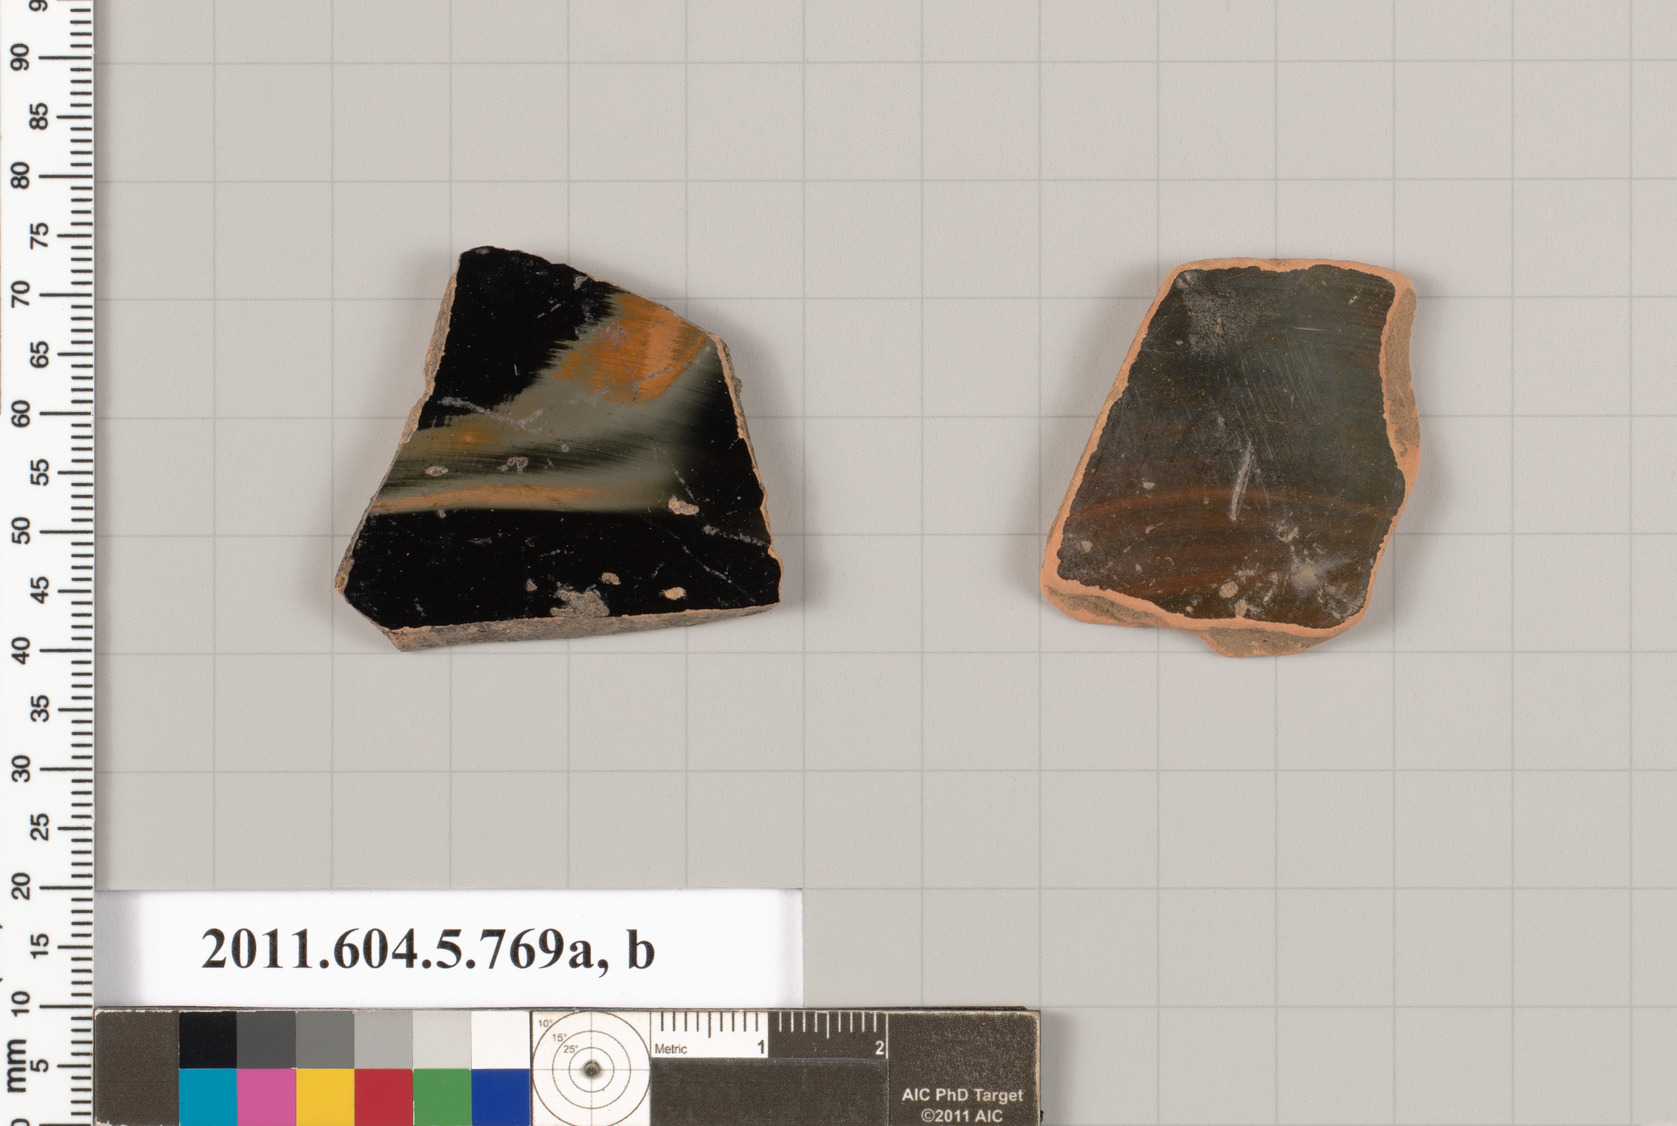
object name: kylix fragment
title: Terracotta fragments of kylikes (drinking cups)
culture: greek, attic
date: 600-401 BCE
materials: terracotta